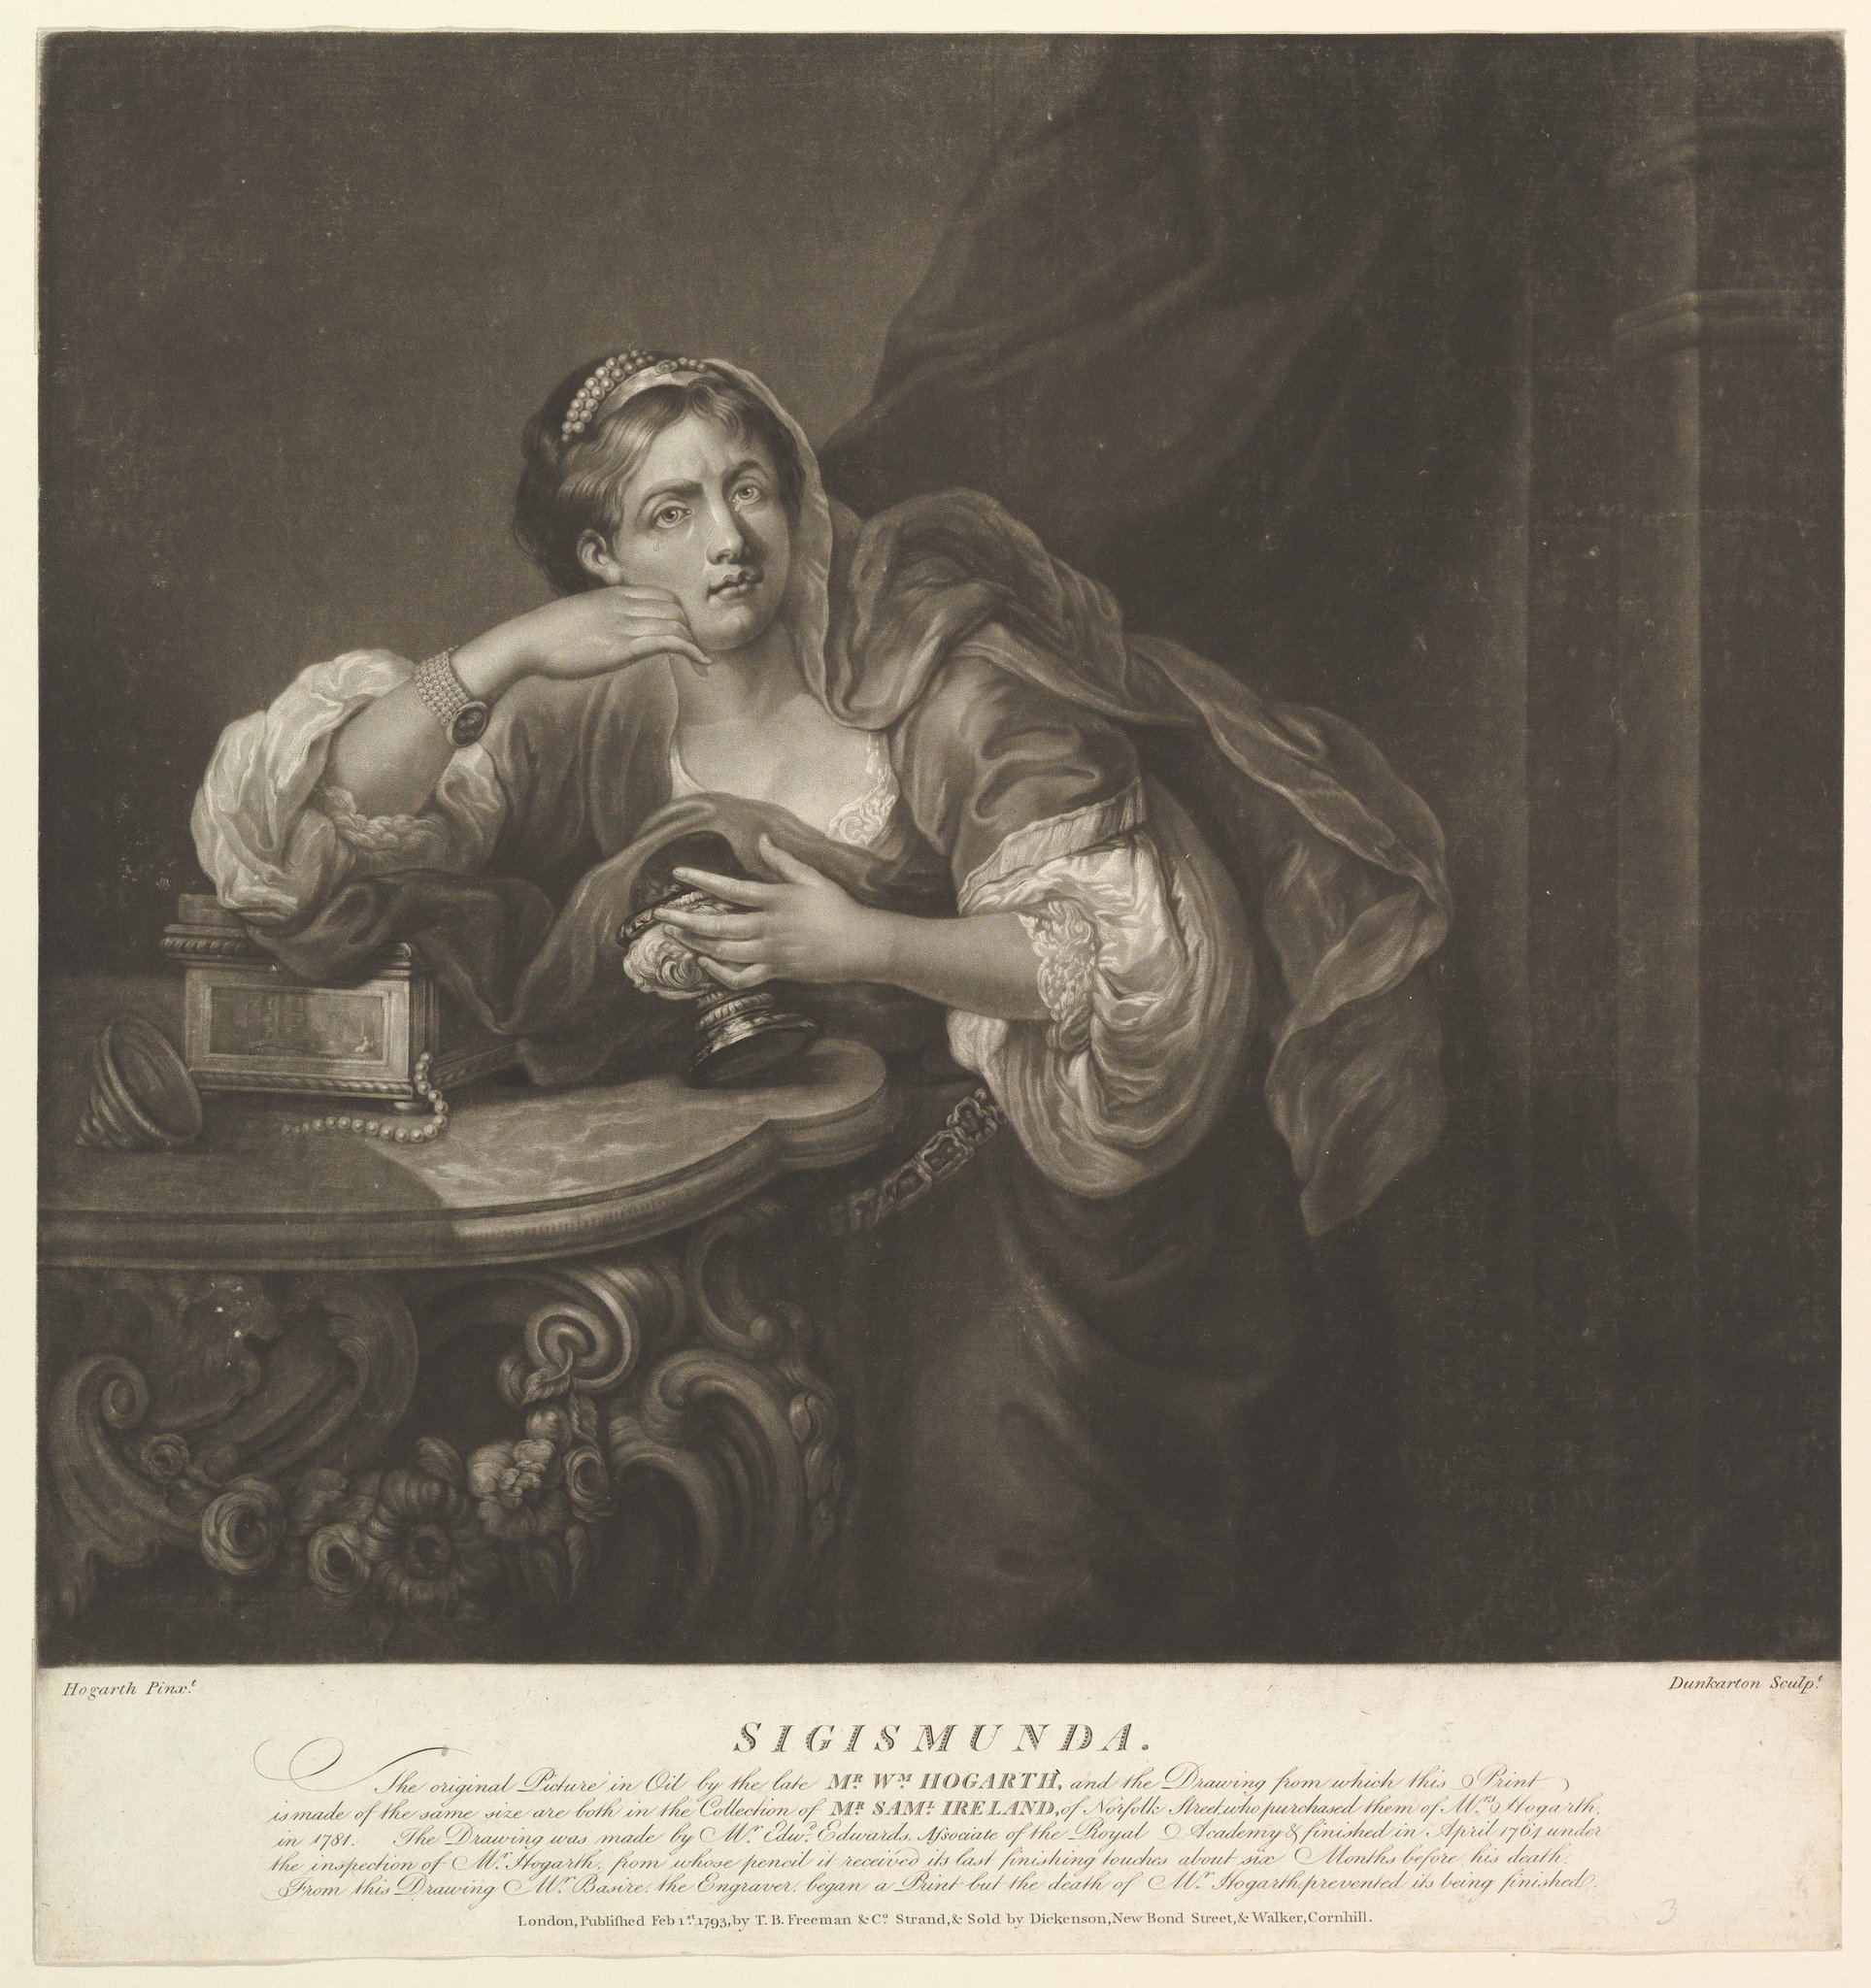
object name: print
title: Sigismunda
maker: robert dunkarton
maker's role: engraver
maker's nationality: british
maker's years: 1744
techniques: mezzotint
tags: women,tables